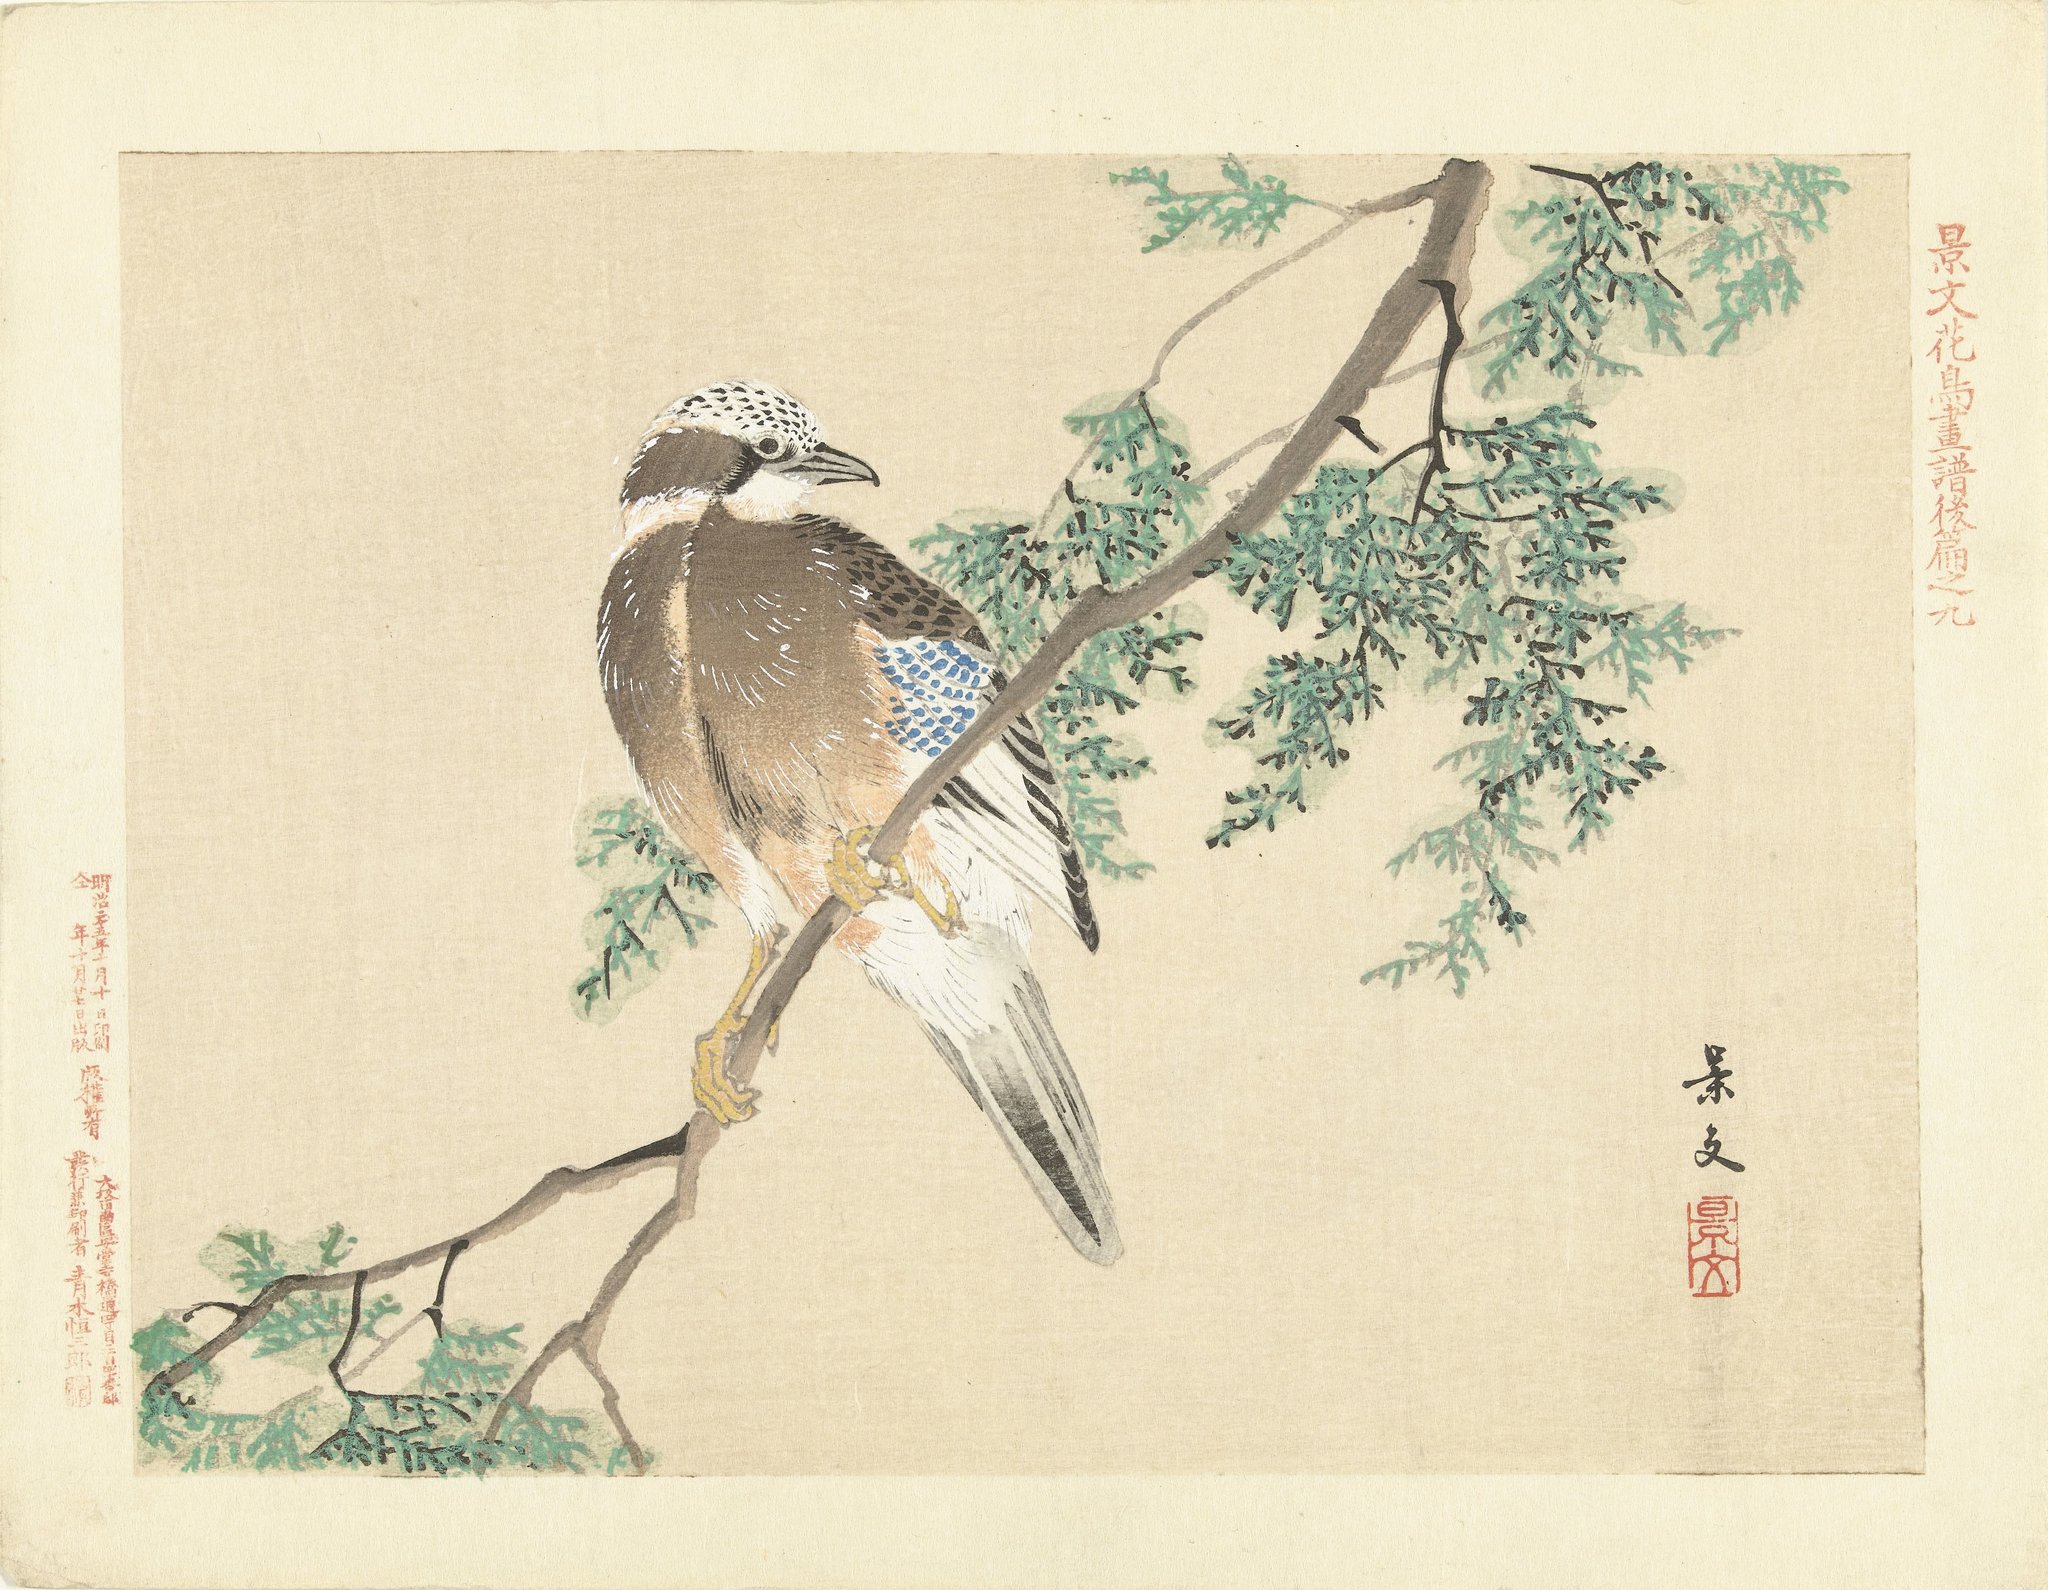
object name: print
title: Jay on a branch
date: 1810-1892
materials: paper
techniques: woodcut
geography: osaka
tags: plants; vegetation, song-birds: jay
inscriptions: collector's mark: Lugt 2228, collector's mark: ‘Rijksschool voor kunstnijverheid’ Lugt 3937